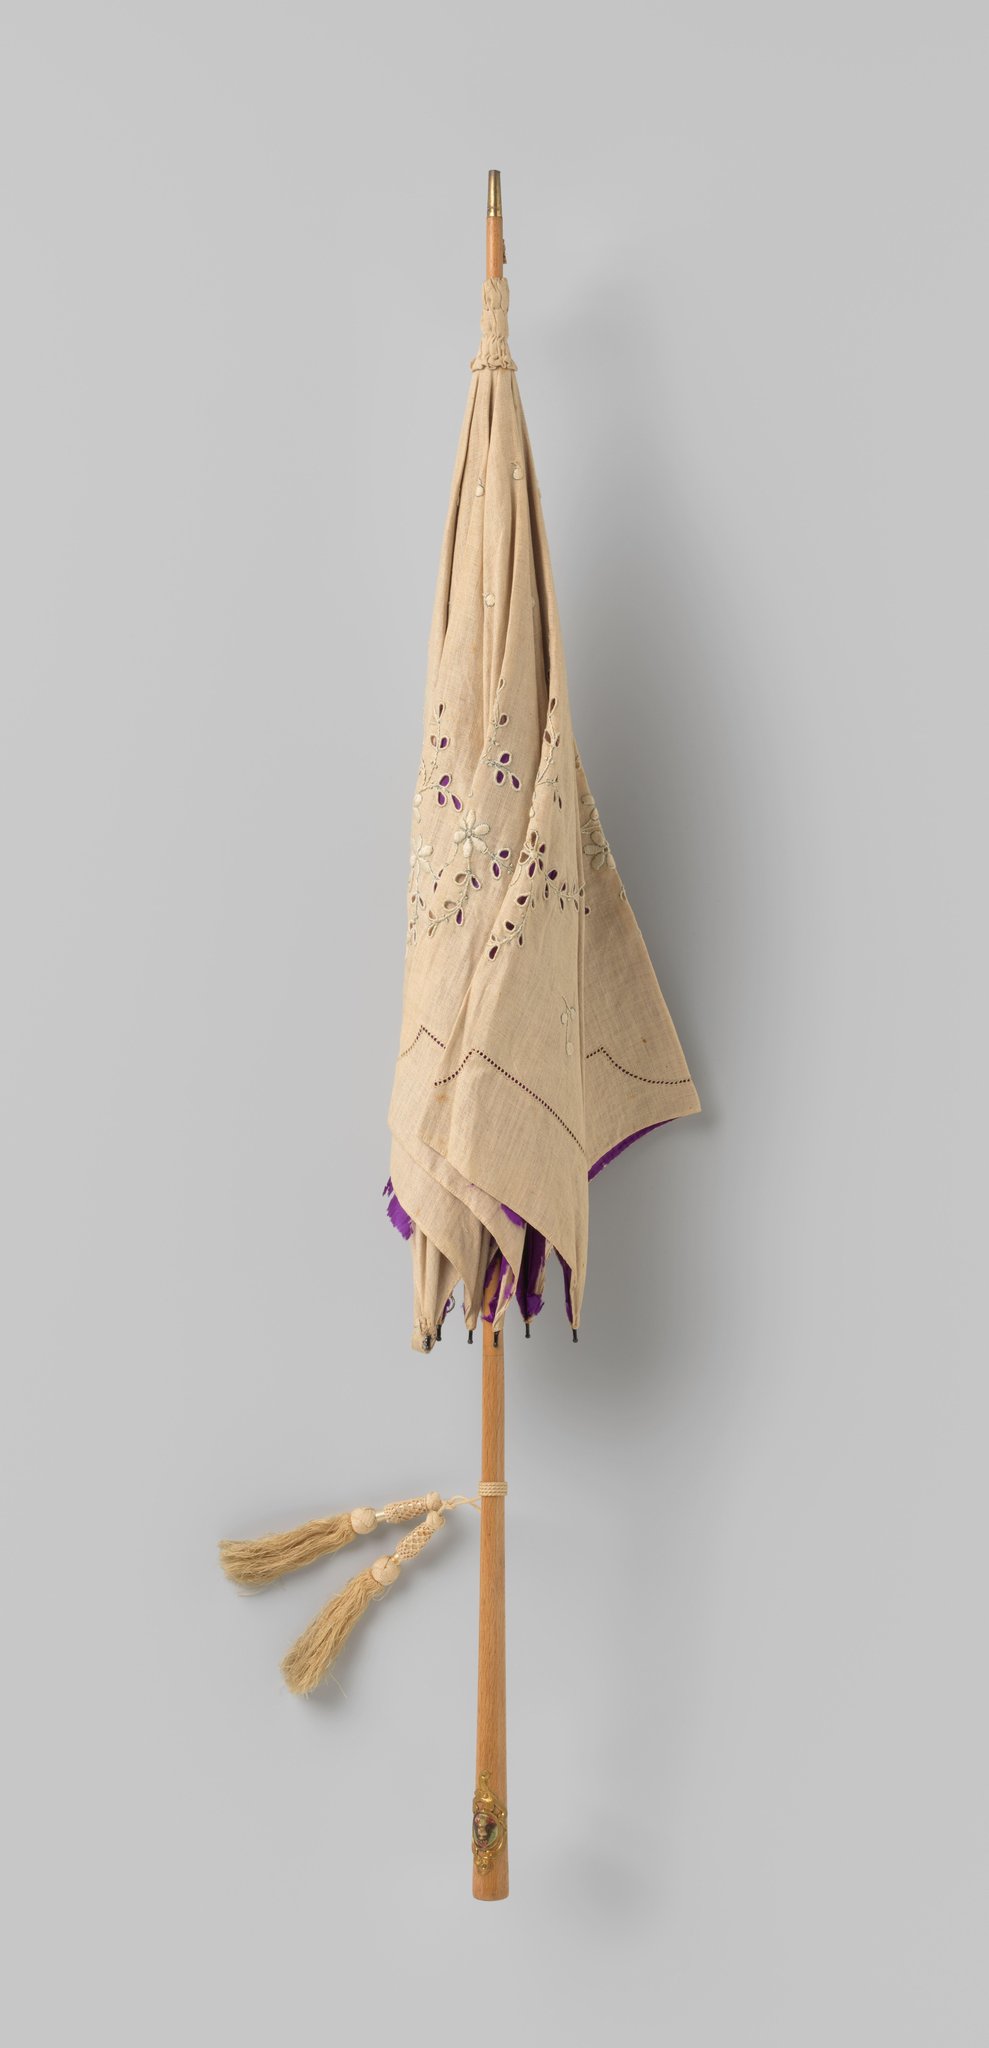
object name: parasol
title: Parasol met dek van écrukleurig linnen waarop in dezelfde kleur (open) borduurwerk, gevoerd met paarse zijde, op een konische lichte houten stok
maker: Anonymous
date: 1908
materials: copper, linen, silk, wood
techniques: braiding, cutting, embroidery, embroidered, inlay, weave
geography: netherlands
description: Parasol van écrukleurig linnen met wit borduursel. Iedere sector is recht afgwerkt en van een machinaal ajourrandje voorzien, terwijl open borduurwerk ('Richelieu-werk') is aangebracht in de vorm van slingerende stelen, waaraan zesbladige rozetbloempjes en open blaadjes. Verder wijd uiteen gestrooide bessen. Paarse zijden voering. Acht baleinen. Houten kegelvormige knop met koperen applique met portret van een dame. Aan de stok is een koord geknoopt met twee zijden kwasten.